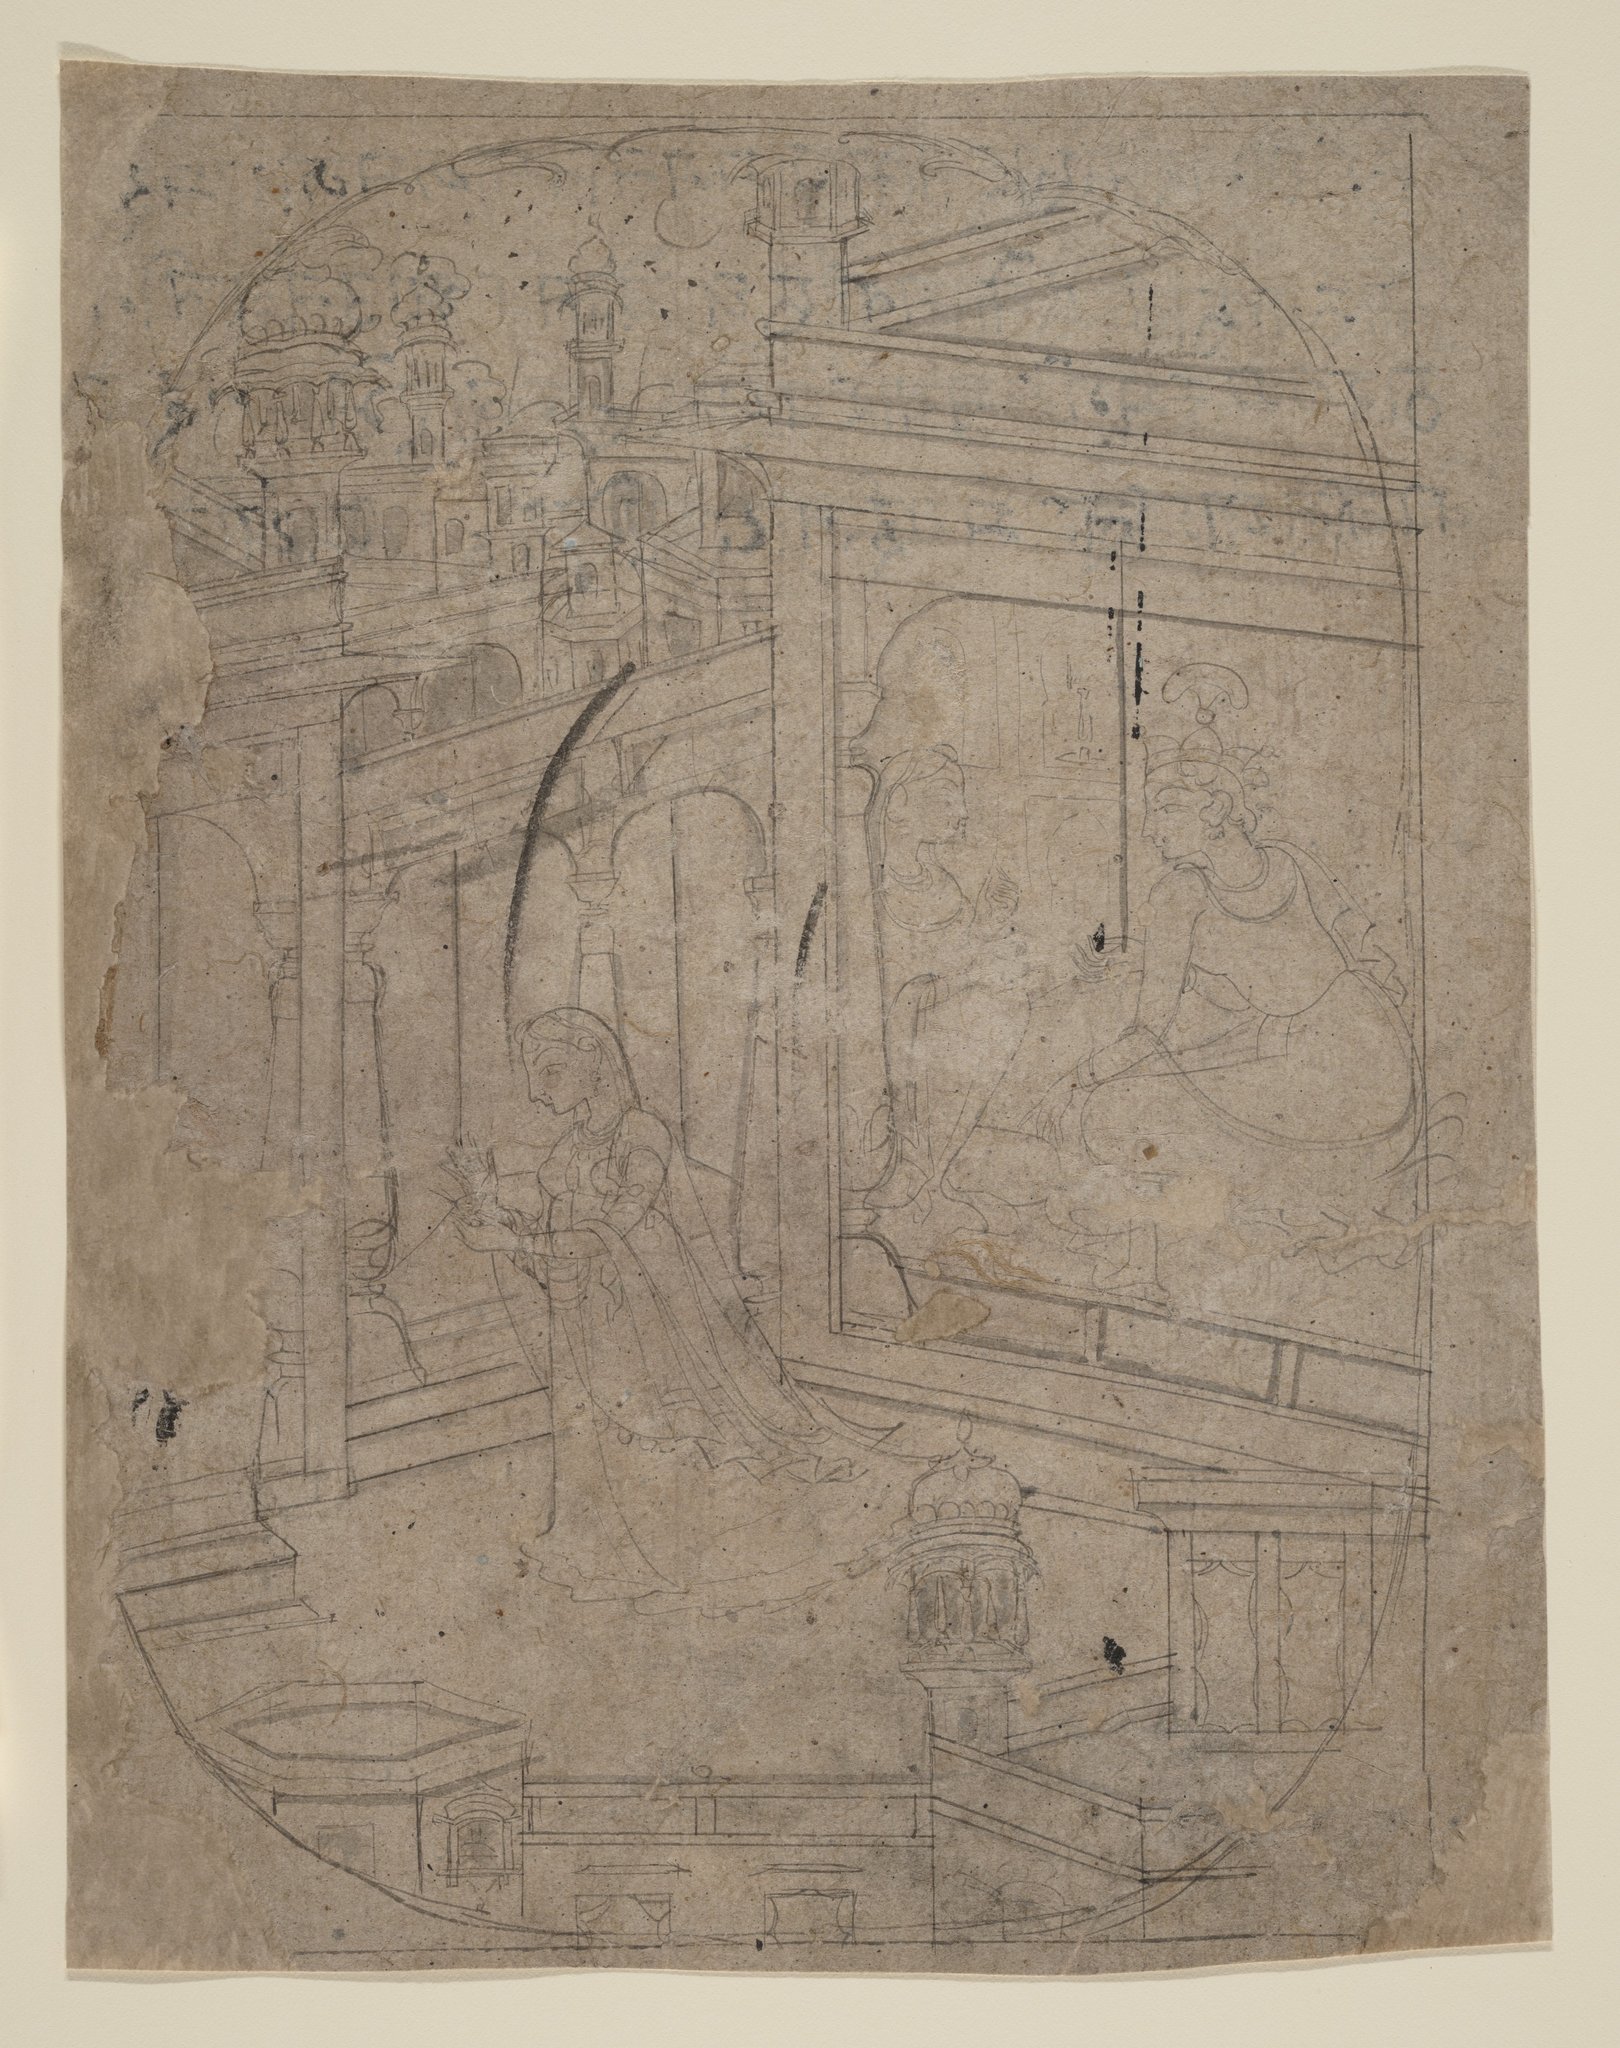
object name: painting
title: Woman Leaving Her Lover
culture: indian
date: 1790-1820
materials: ink, paper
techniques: wash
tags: men,women